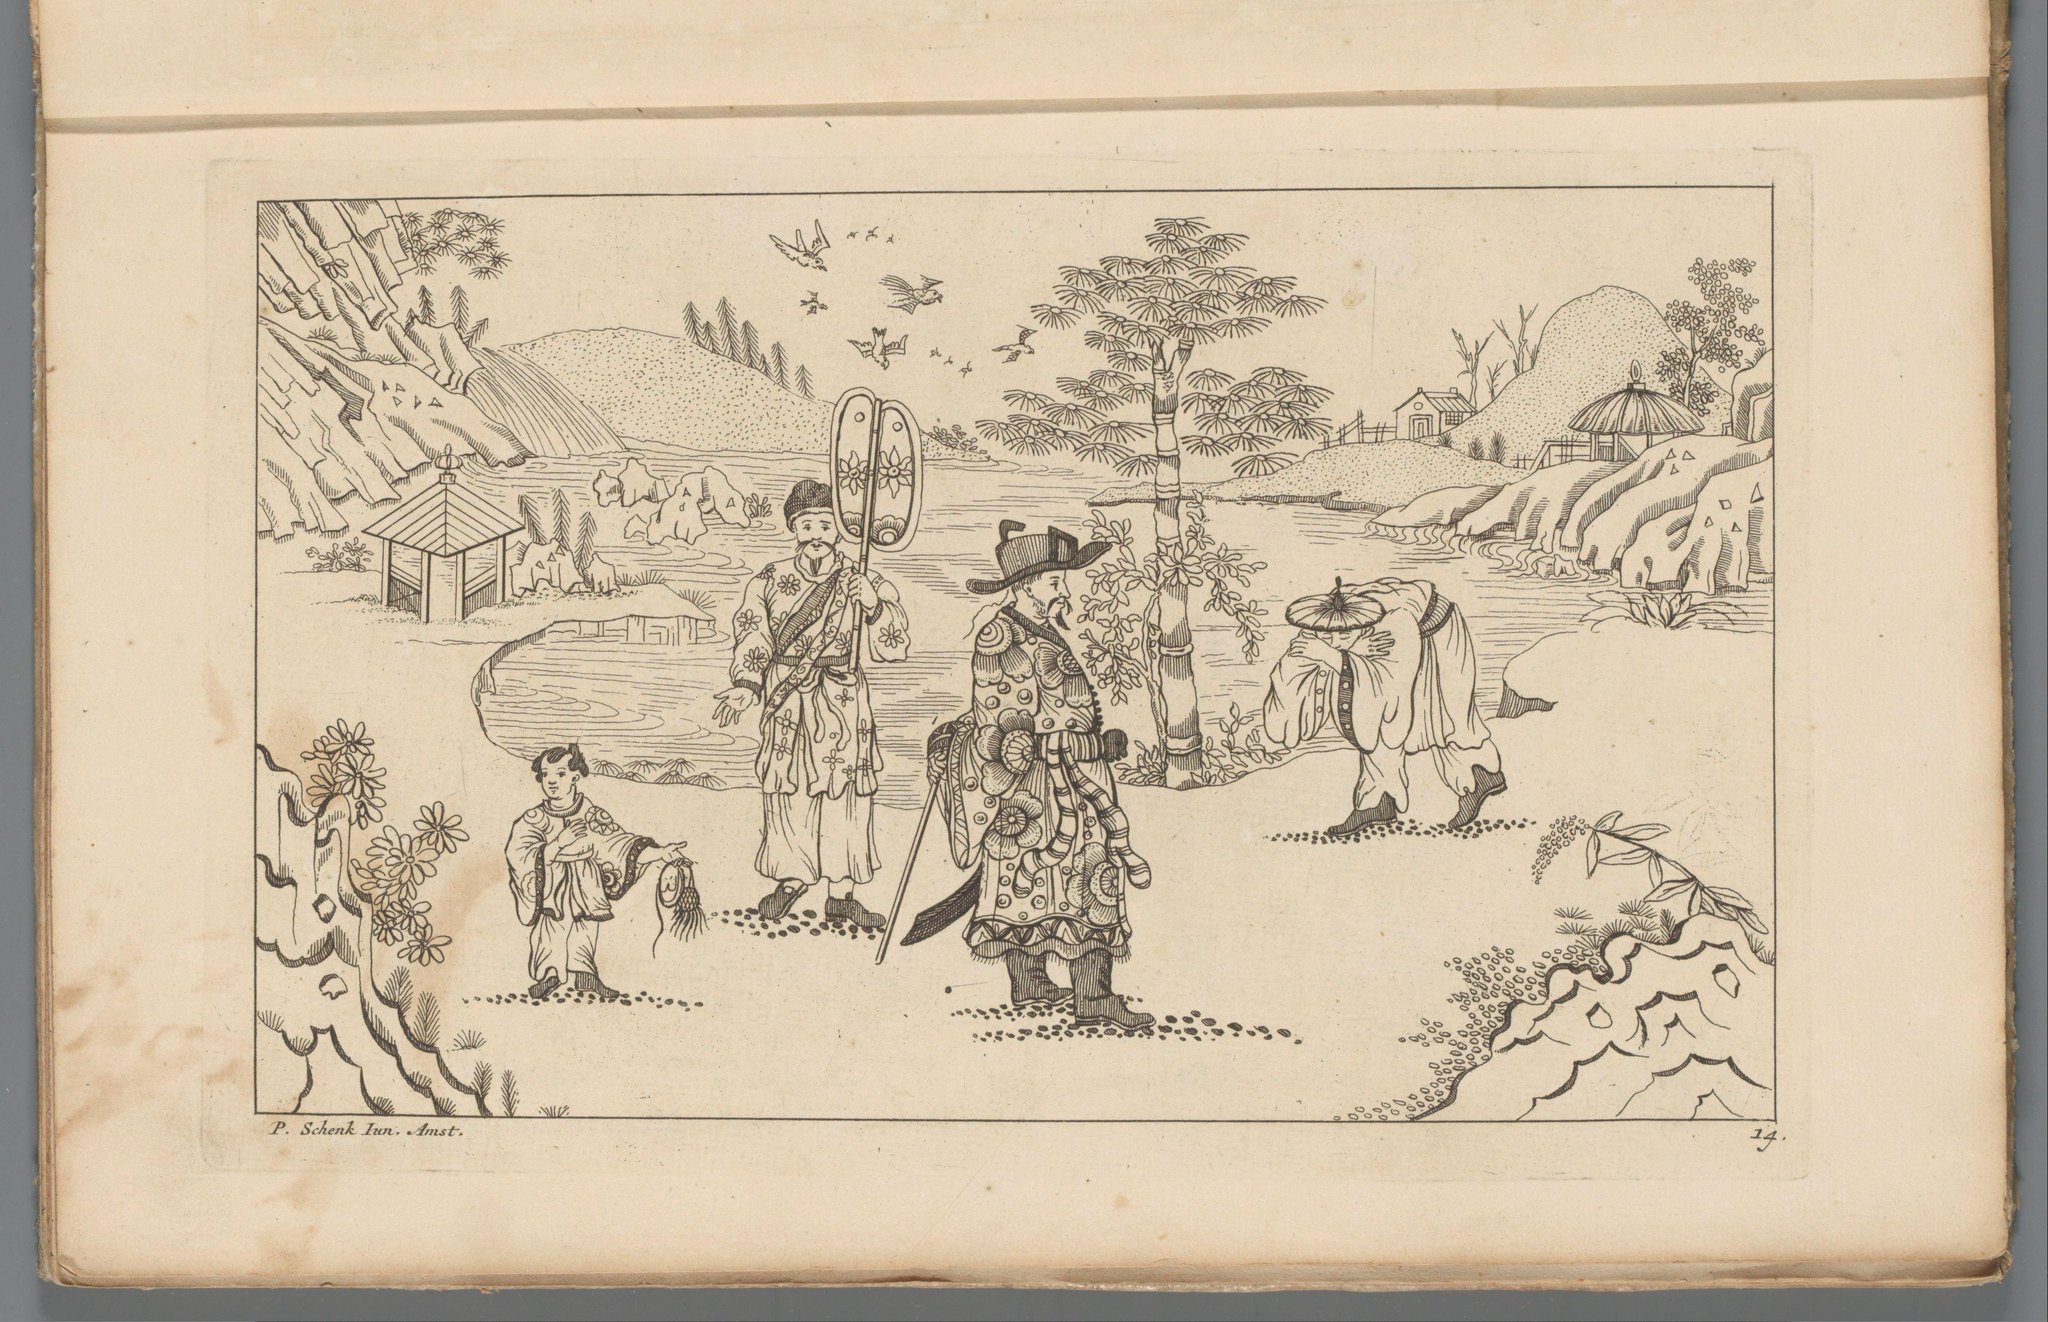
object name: album leaf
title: Nieuwe geinventeerde Sineesen met groote moeyte geteekent en in 't Ligt gegeven, door P. Schenk Jun (...), tweede deel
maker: pieter schenk (ii)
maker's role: draughtsman, print maker, publisher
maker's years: 1693-1775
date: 1727-1775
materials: paper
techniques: etching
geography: amsterdam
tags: chinese (+ men), chinese (+ costume), landscapes in the temperate zone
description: Vier Chinese figuren in een landschap met water op de achtergrond. Links een kind. In het midden twee rijk uitgedoste Chinese mannen. Rechts een man die buigt. Prent maakt deel uit van een album.